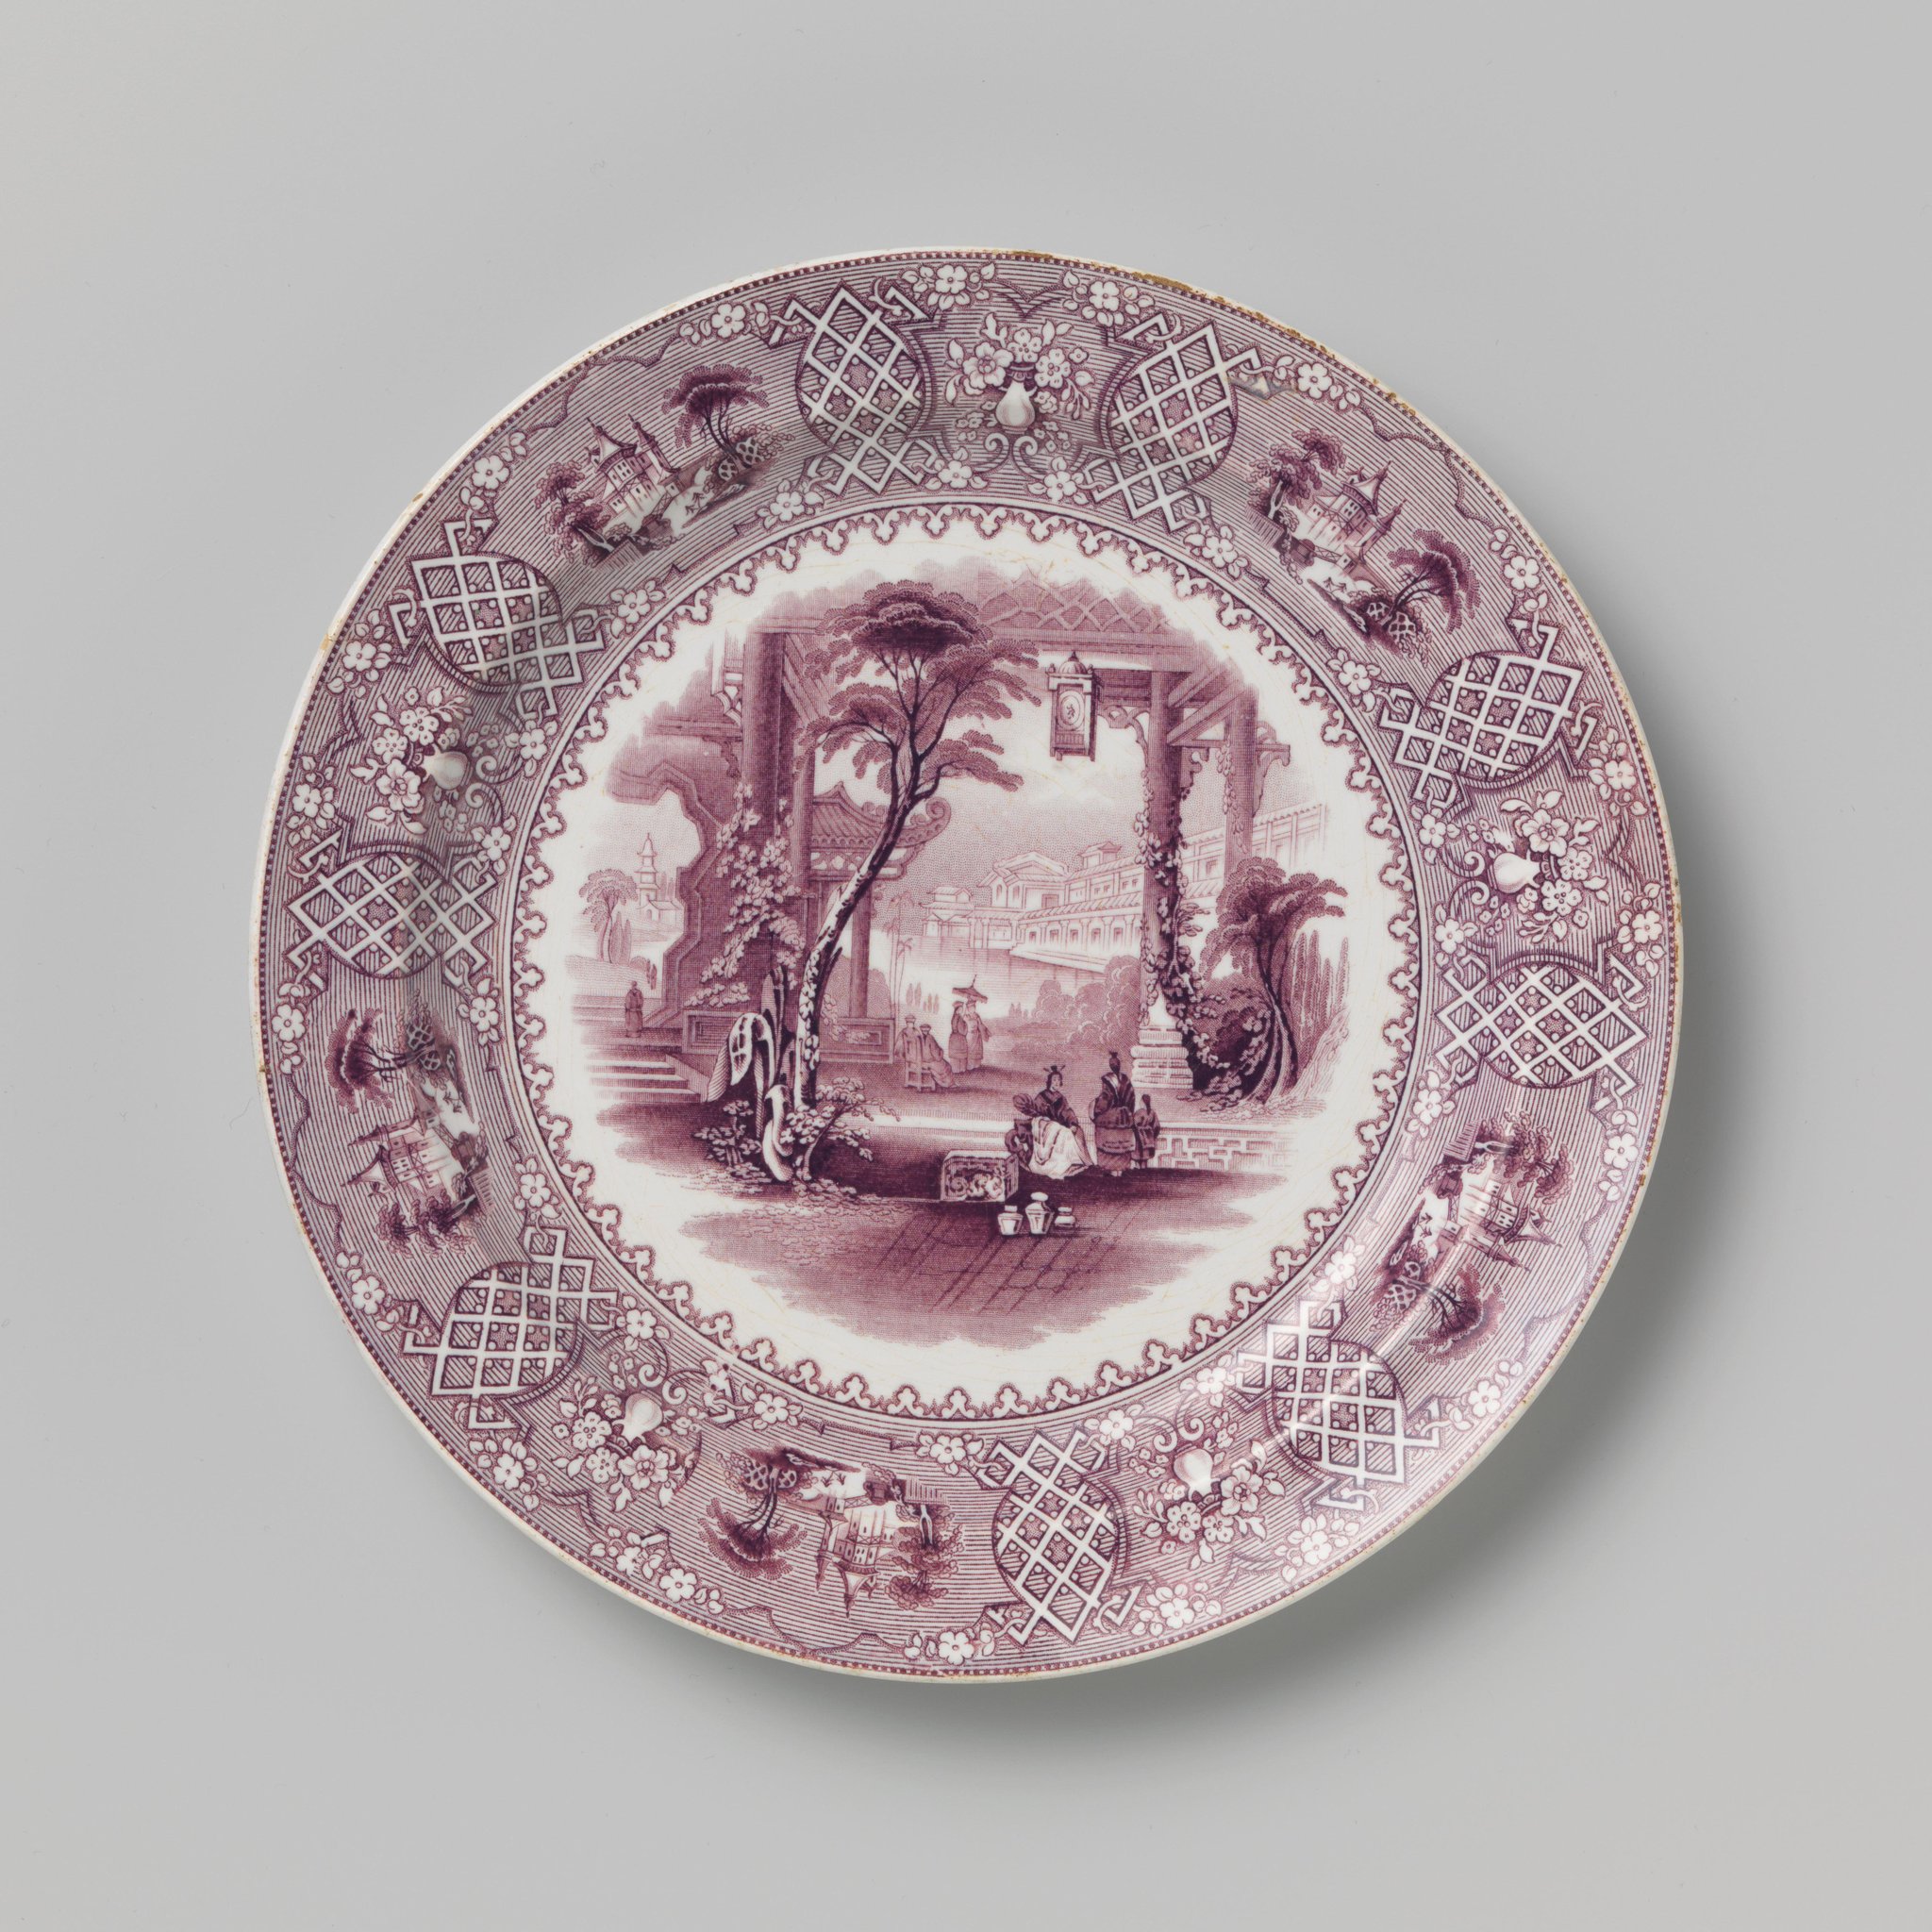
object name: plate dish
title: Bord met op het plat een gezicht op een chinese stad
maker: petrus regout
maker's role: plateelbakker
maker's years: 1801-1879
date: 1850-1875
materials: creamware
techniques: transfer decoration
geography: maastricht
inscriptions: mark: ‘Staffordshire knot // PR // PRIZE MEDAL // 1851 // FLORA en 2’, check stamp: ‘P. REGOUT // 12 // MAASTRICHT’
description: Bord van aardewerk met lila transferdecor, rond, met op het plat een gezicht op een Chinese stad, omgeven door bloemen. Op de rand cartouches met afwisselend vazen met bloemen en gebouwen afgewisseld door hekwerk.